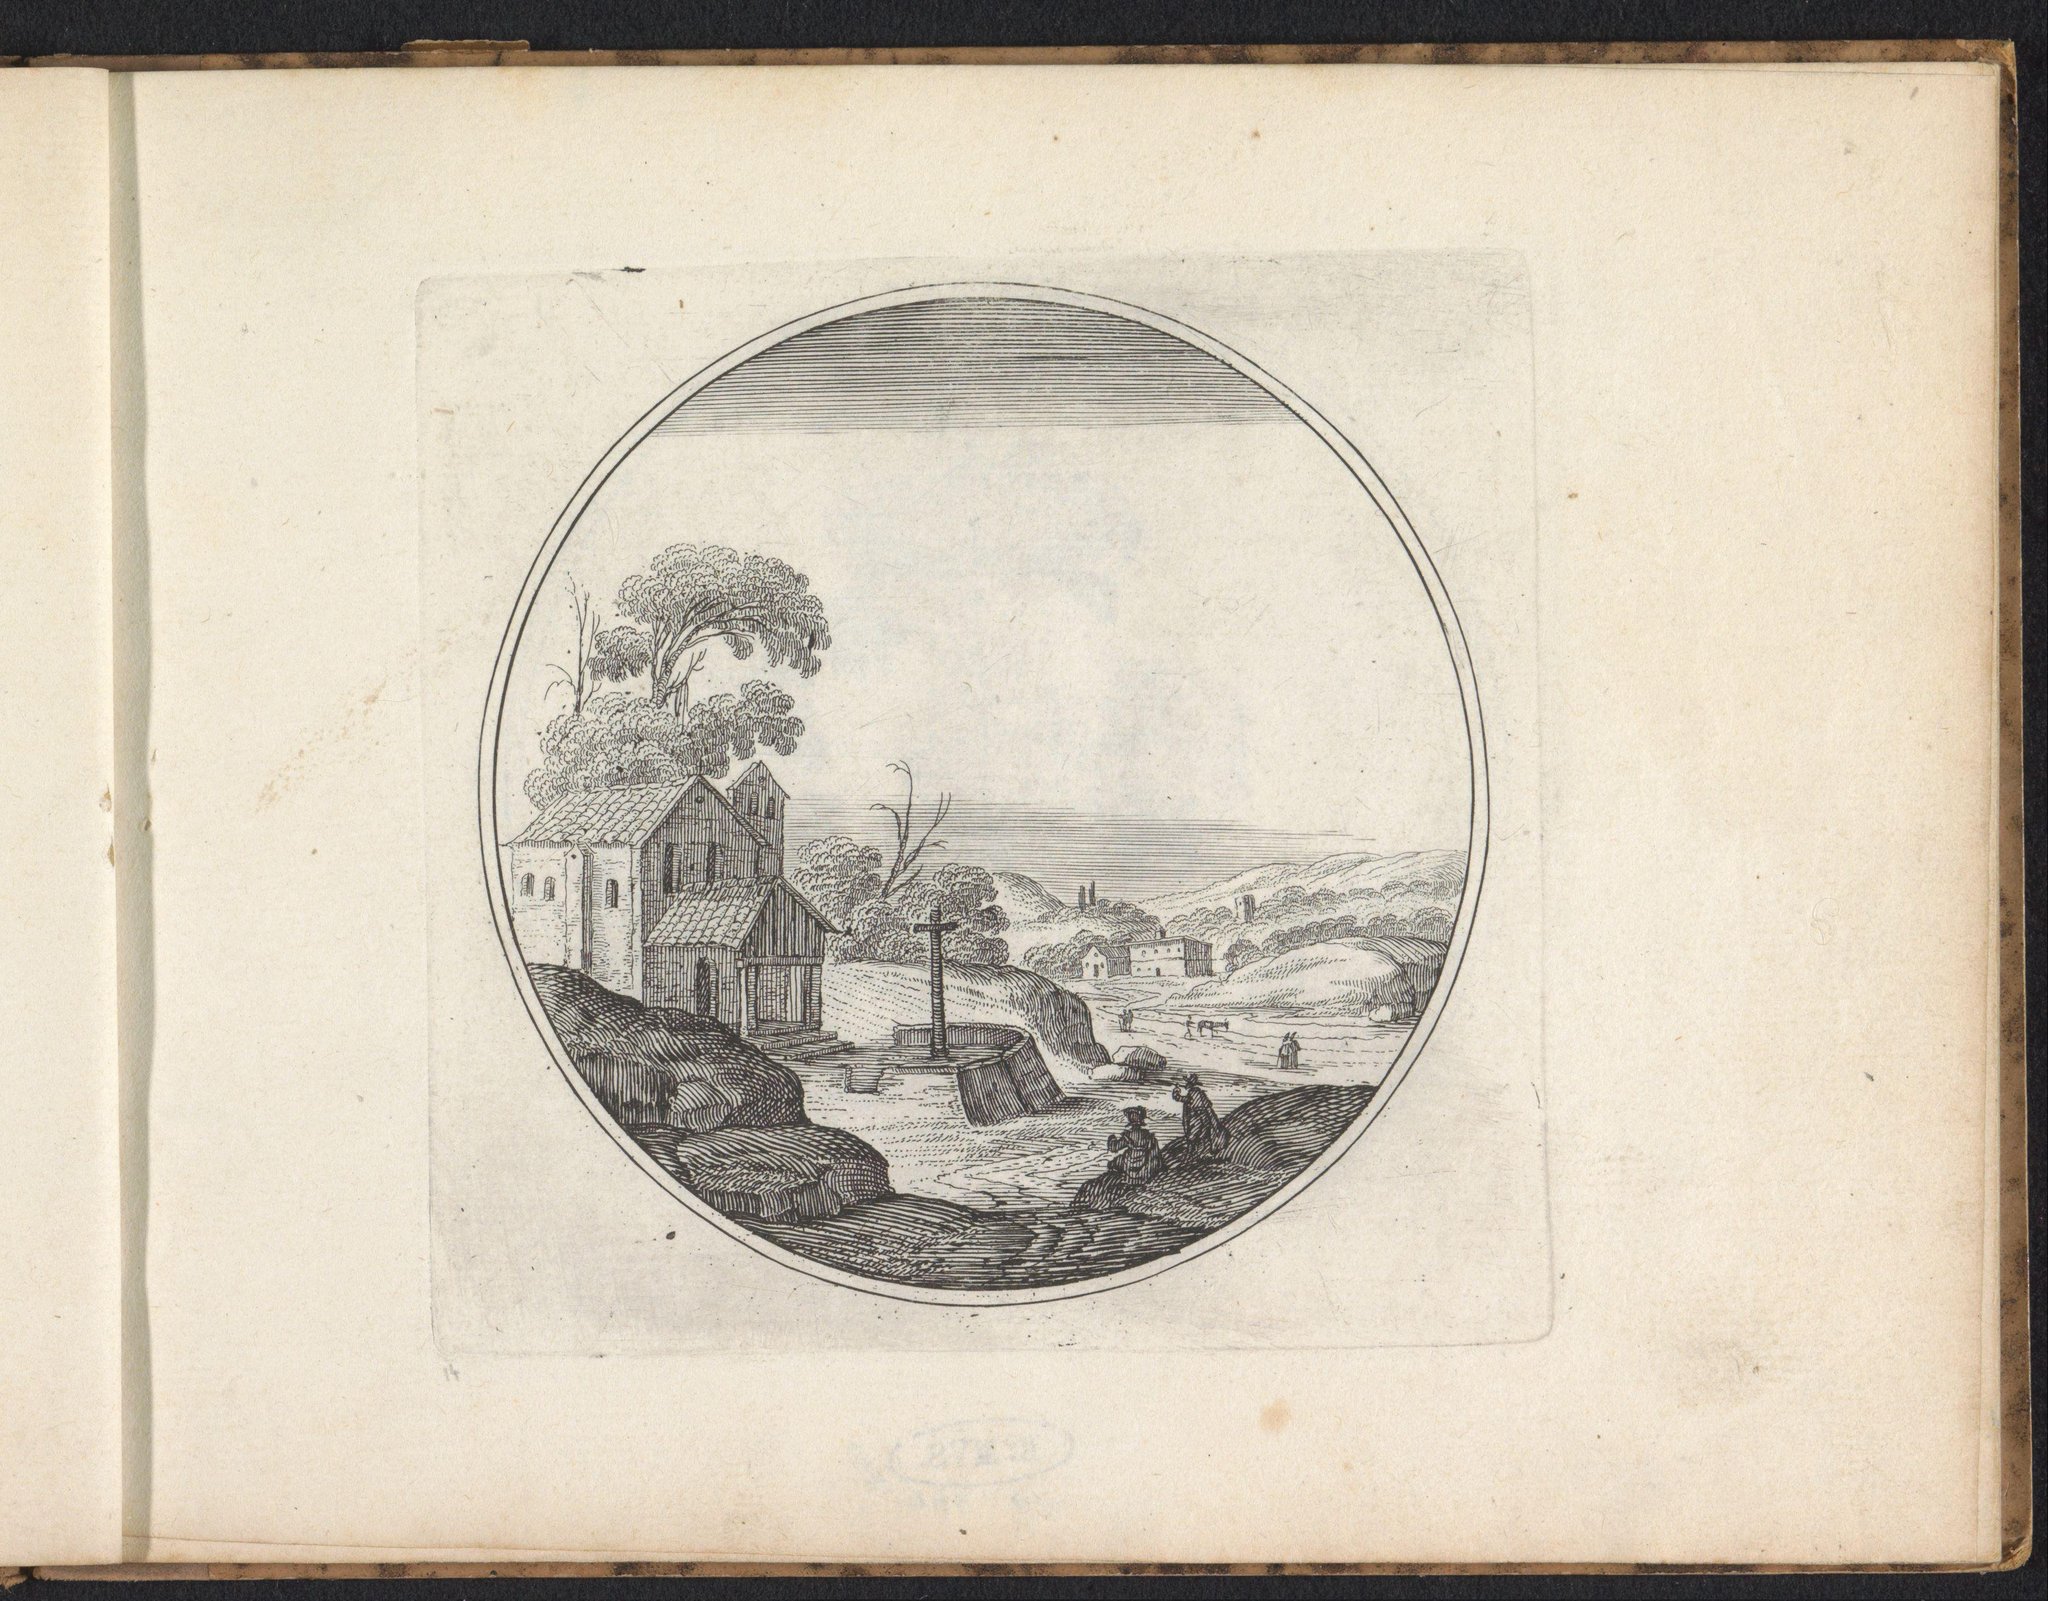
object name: album leaf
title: Ronde landschappen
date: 1626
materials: paper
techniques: etching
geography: northern netherlands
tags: landscapes, church (exterior) - qq - small church, chapel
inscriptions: collector's mark: Lugt 2228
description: Landschap met een weg. Bij de weg staat een kapel met een houten kruis. De prent maakt deel uit van een album.